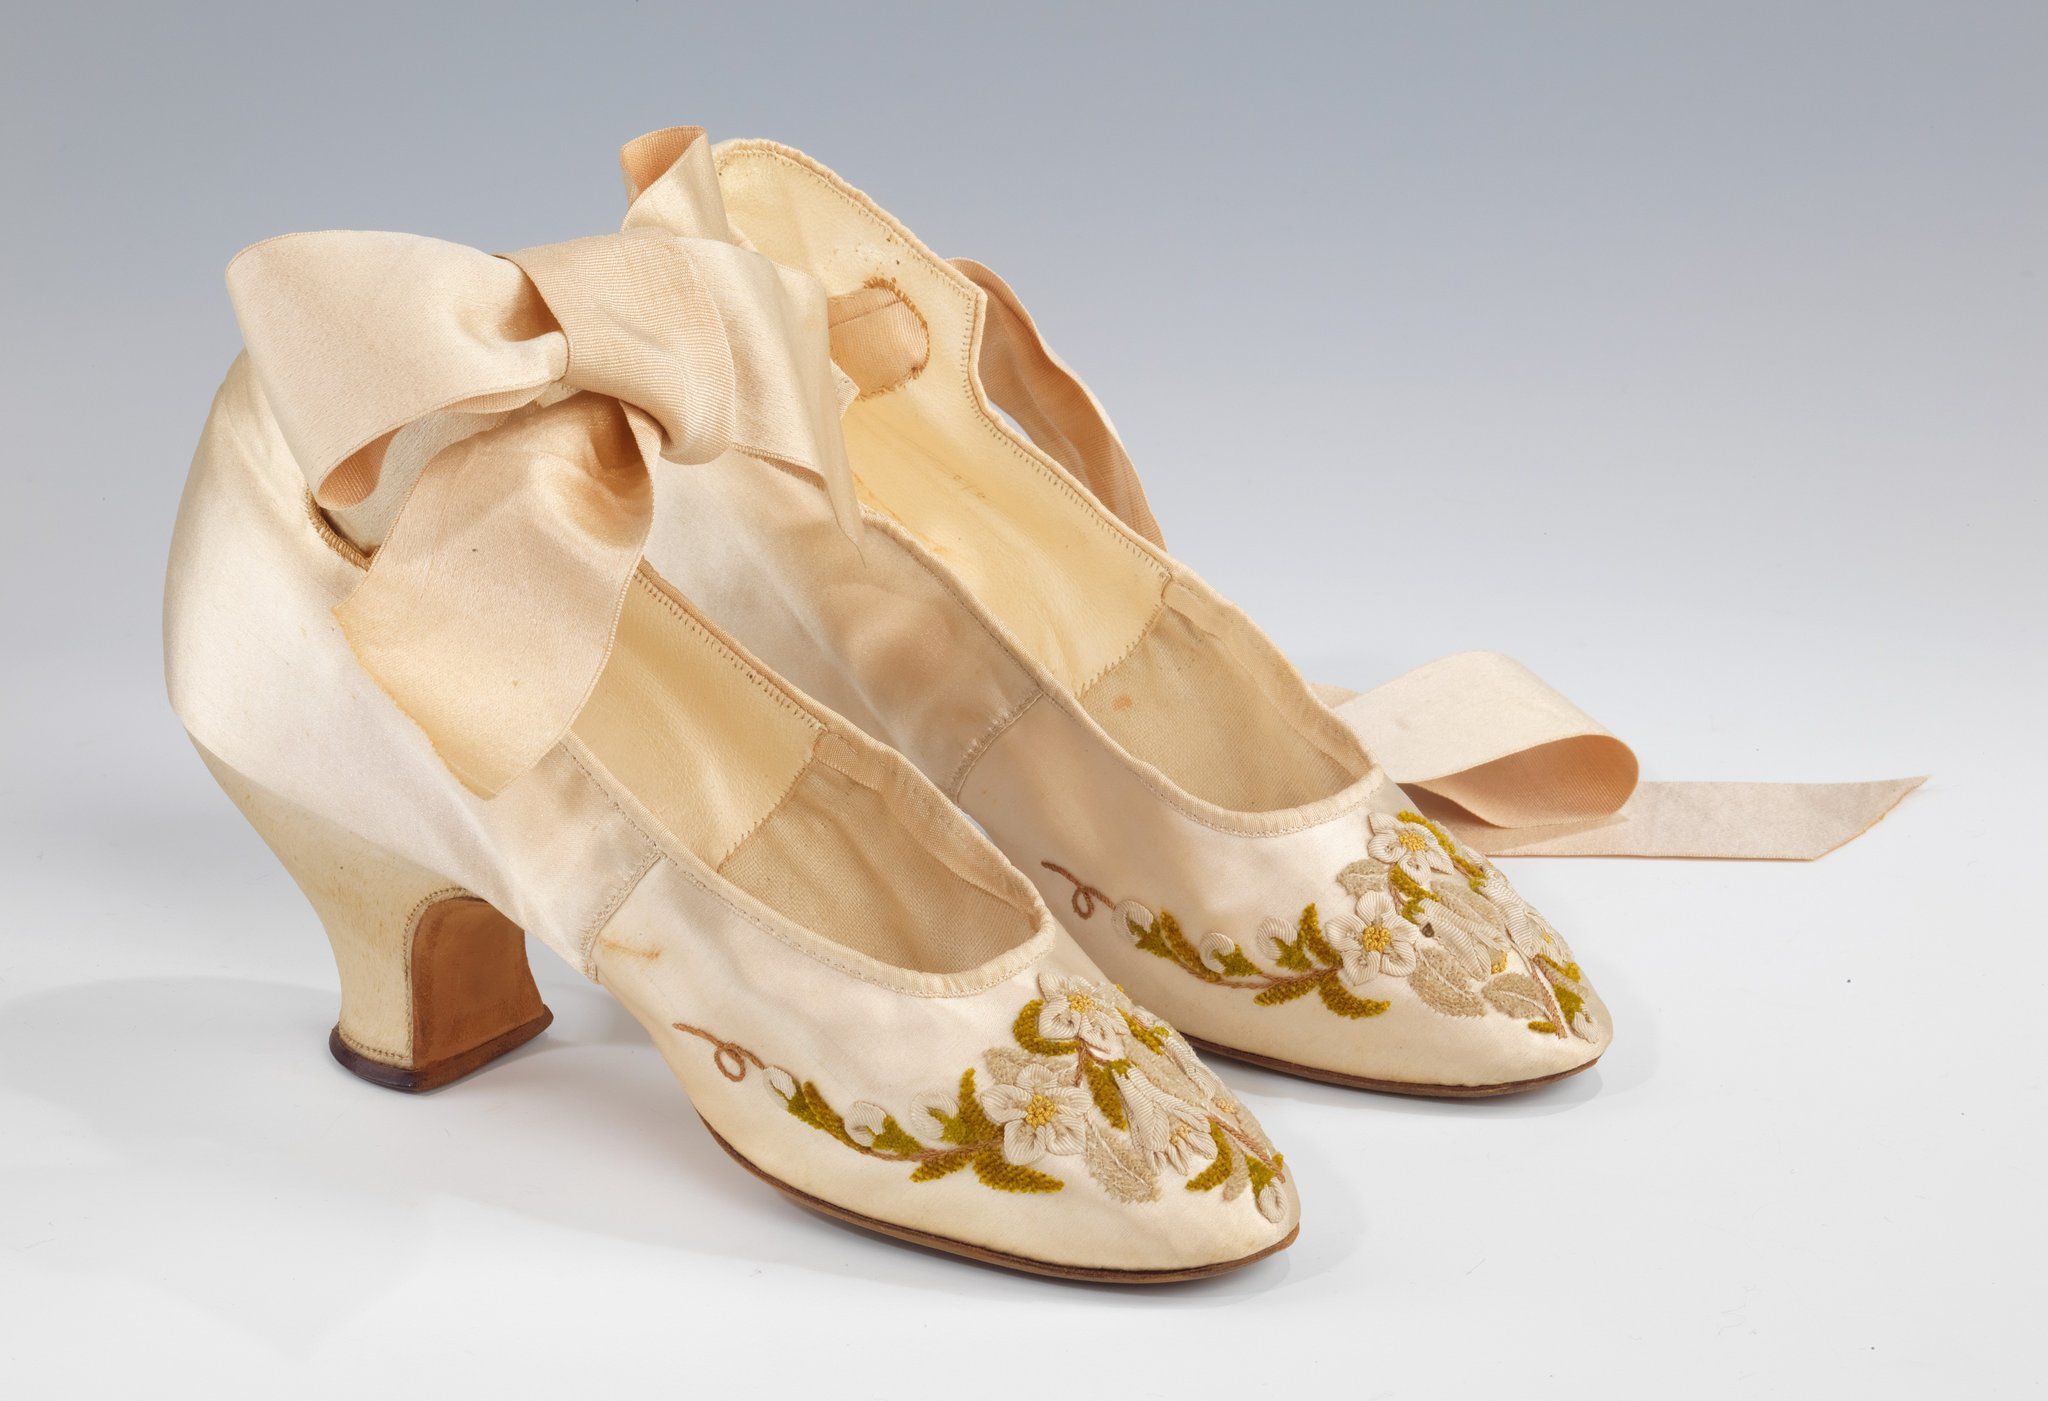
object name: evening shoe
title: Evening shoes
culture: french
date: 1875-1885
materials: silk